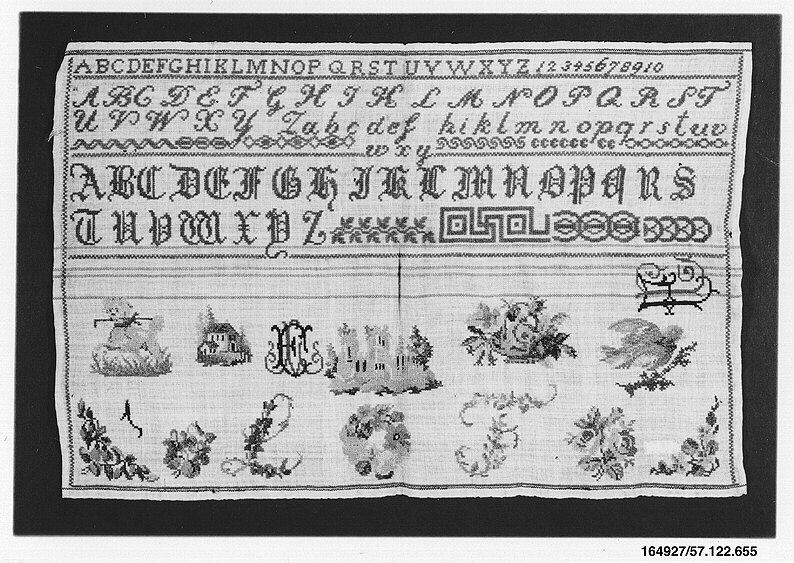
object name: sampler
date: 1801-1900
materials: canvas, silk, wool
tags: houses,flowers